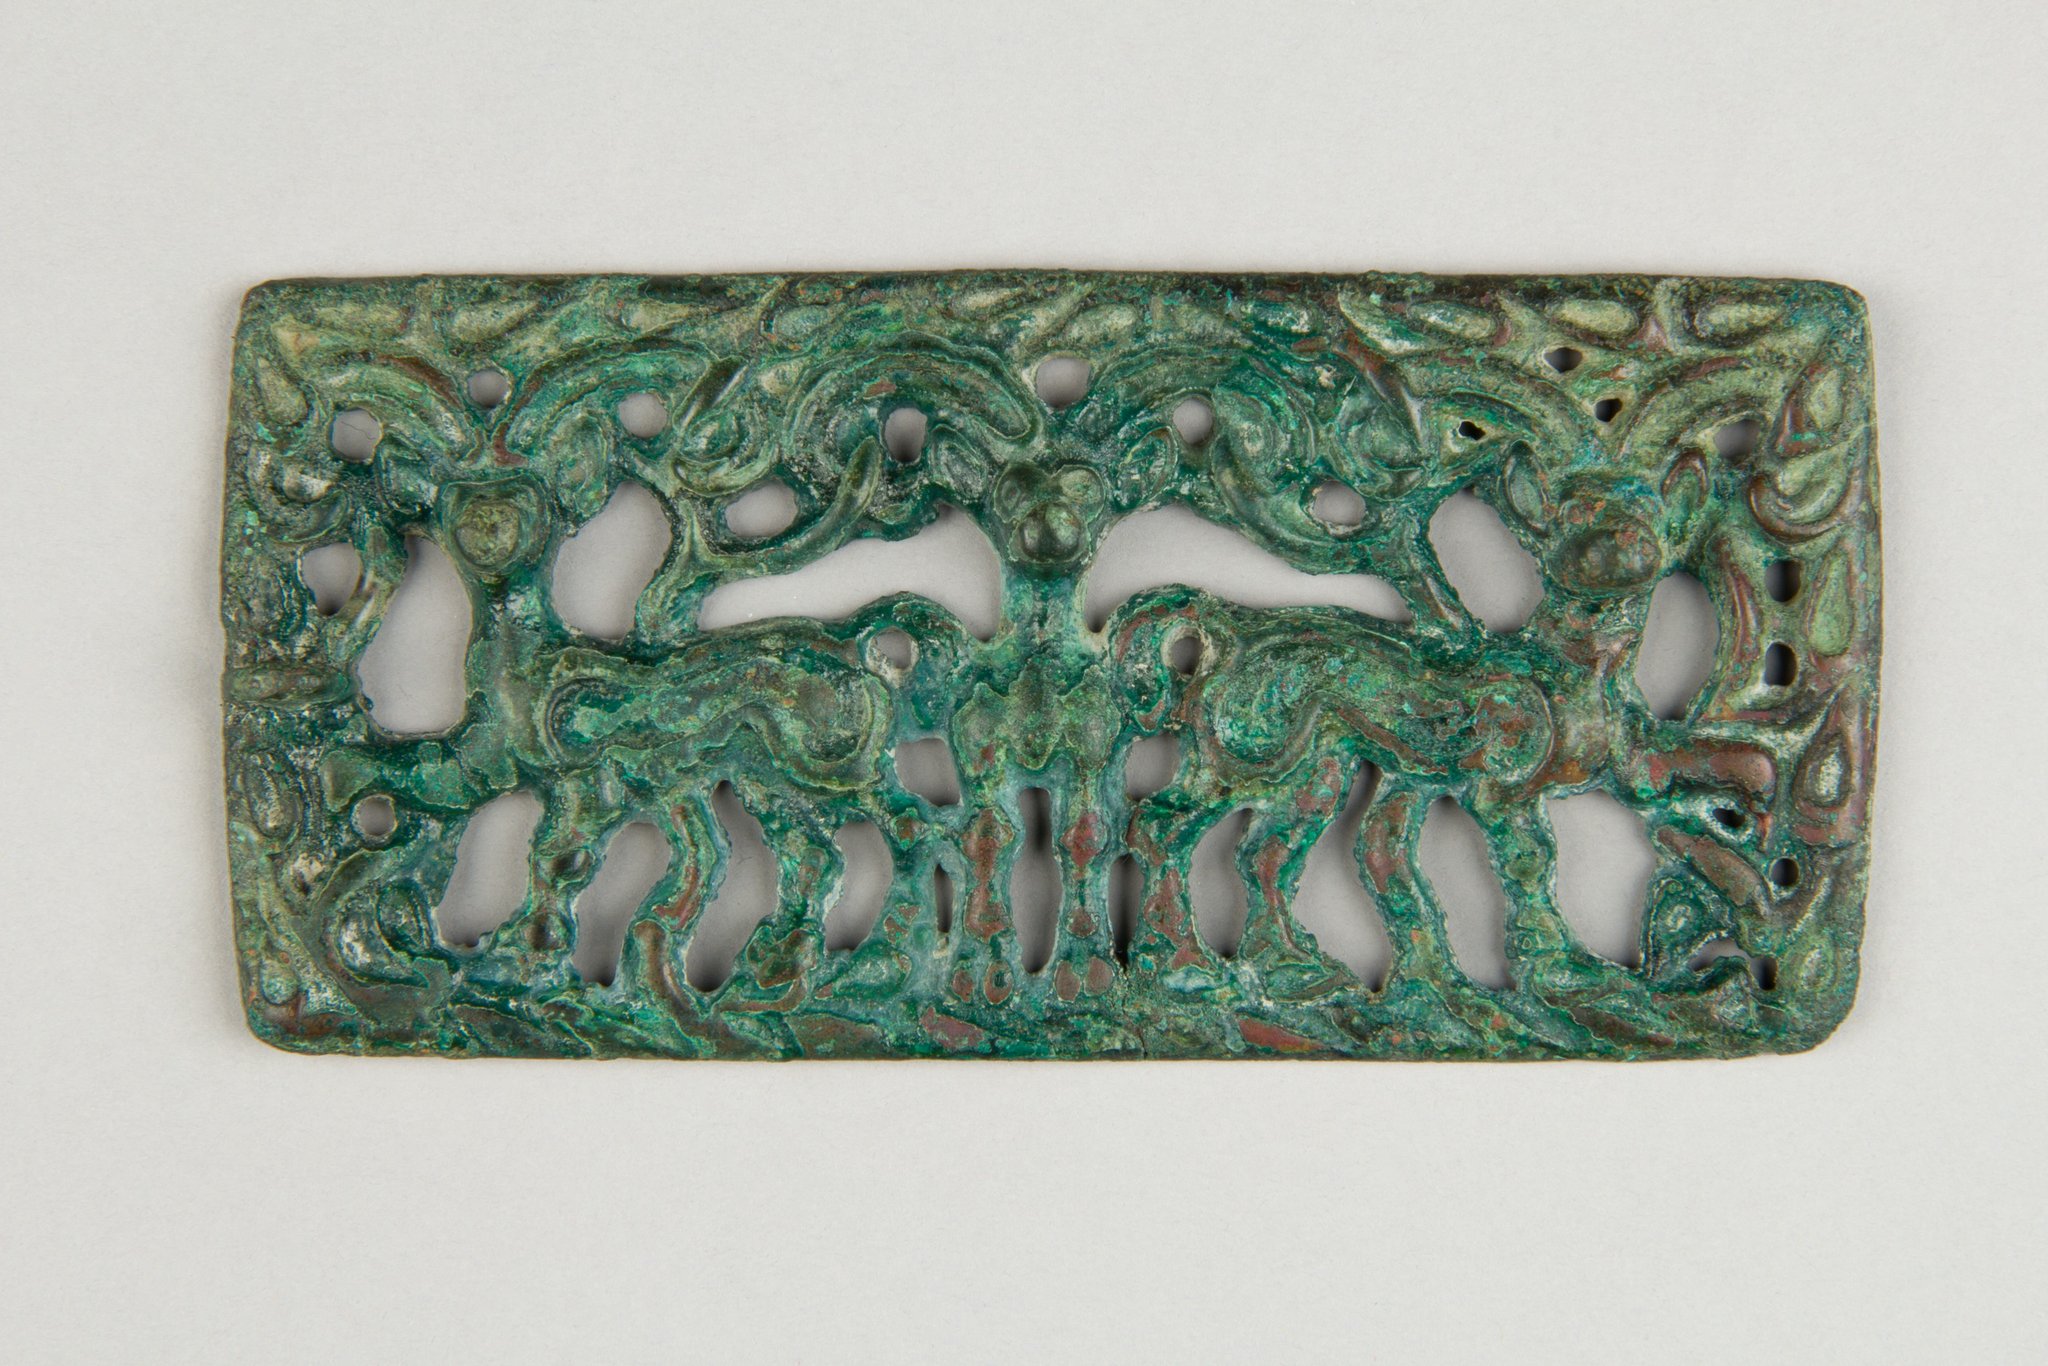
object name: belt plaque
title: Belt Plaque with Three Ibex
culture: northwest chinese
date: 200-1 BCE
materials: bronze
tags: ibex